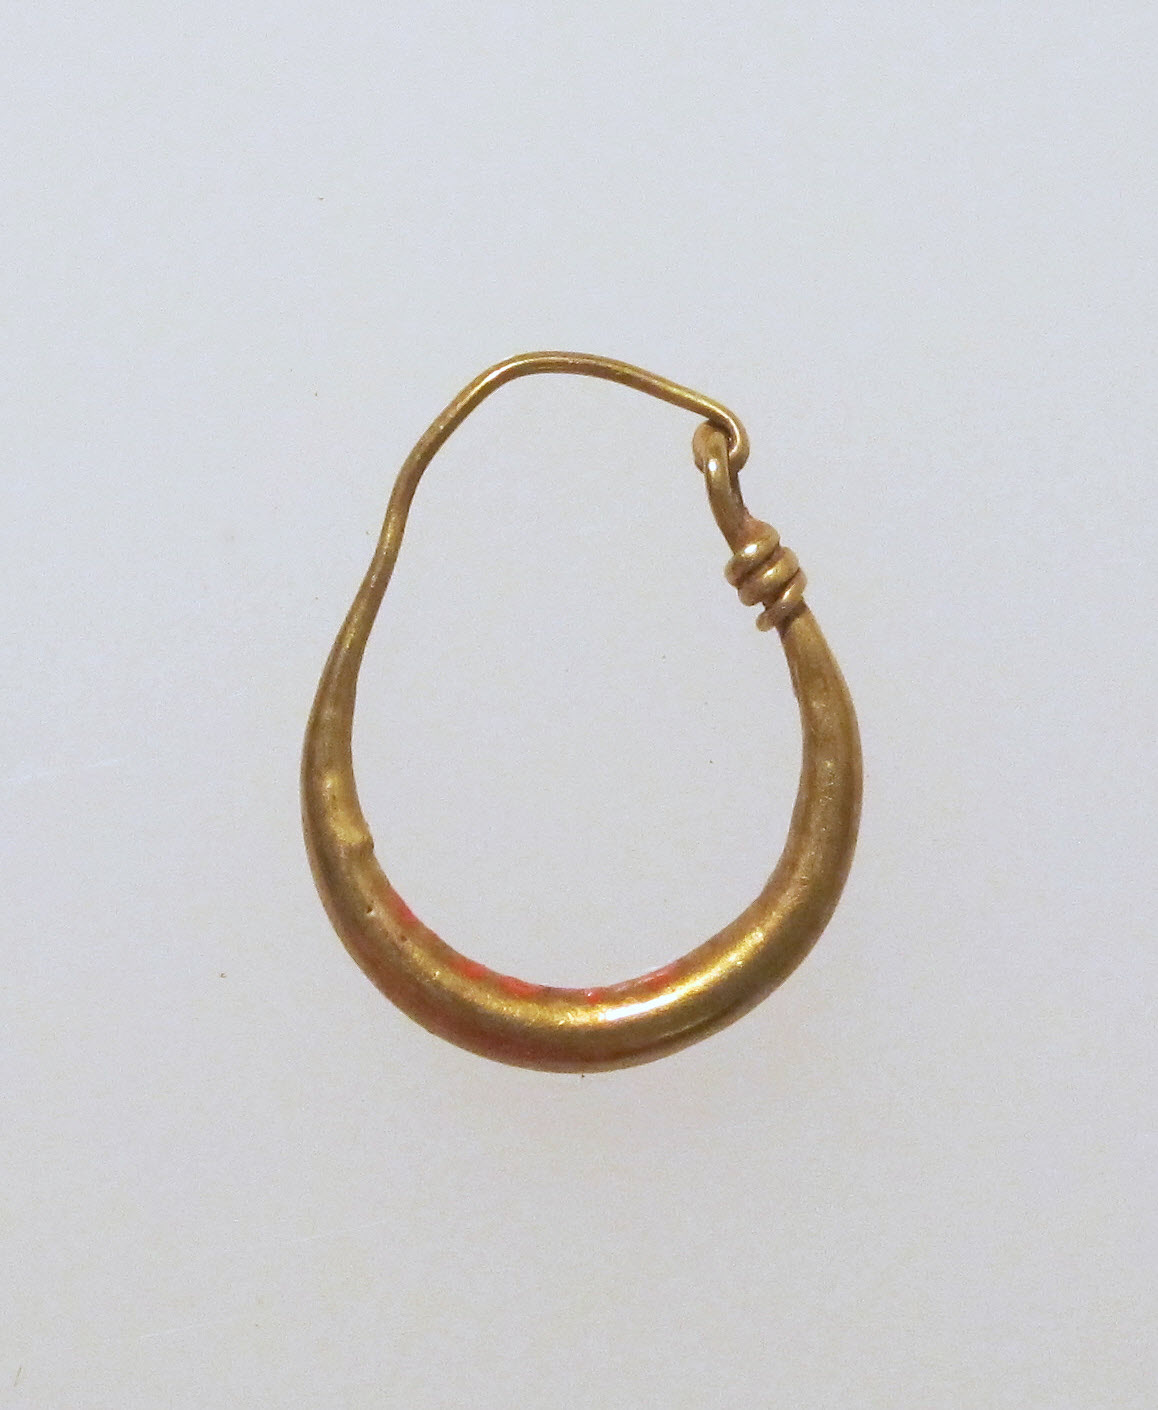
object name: earring loop type, plain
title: Earring-loop type, plain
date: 7000 BCE-330 CE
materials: gold